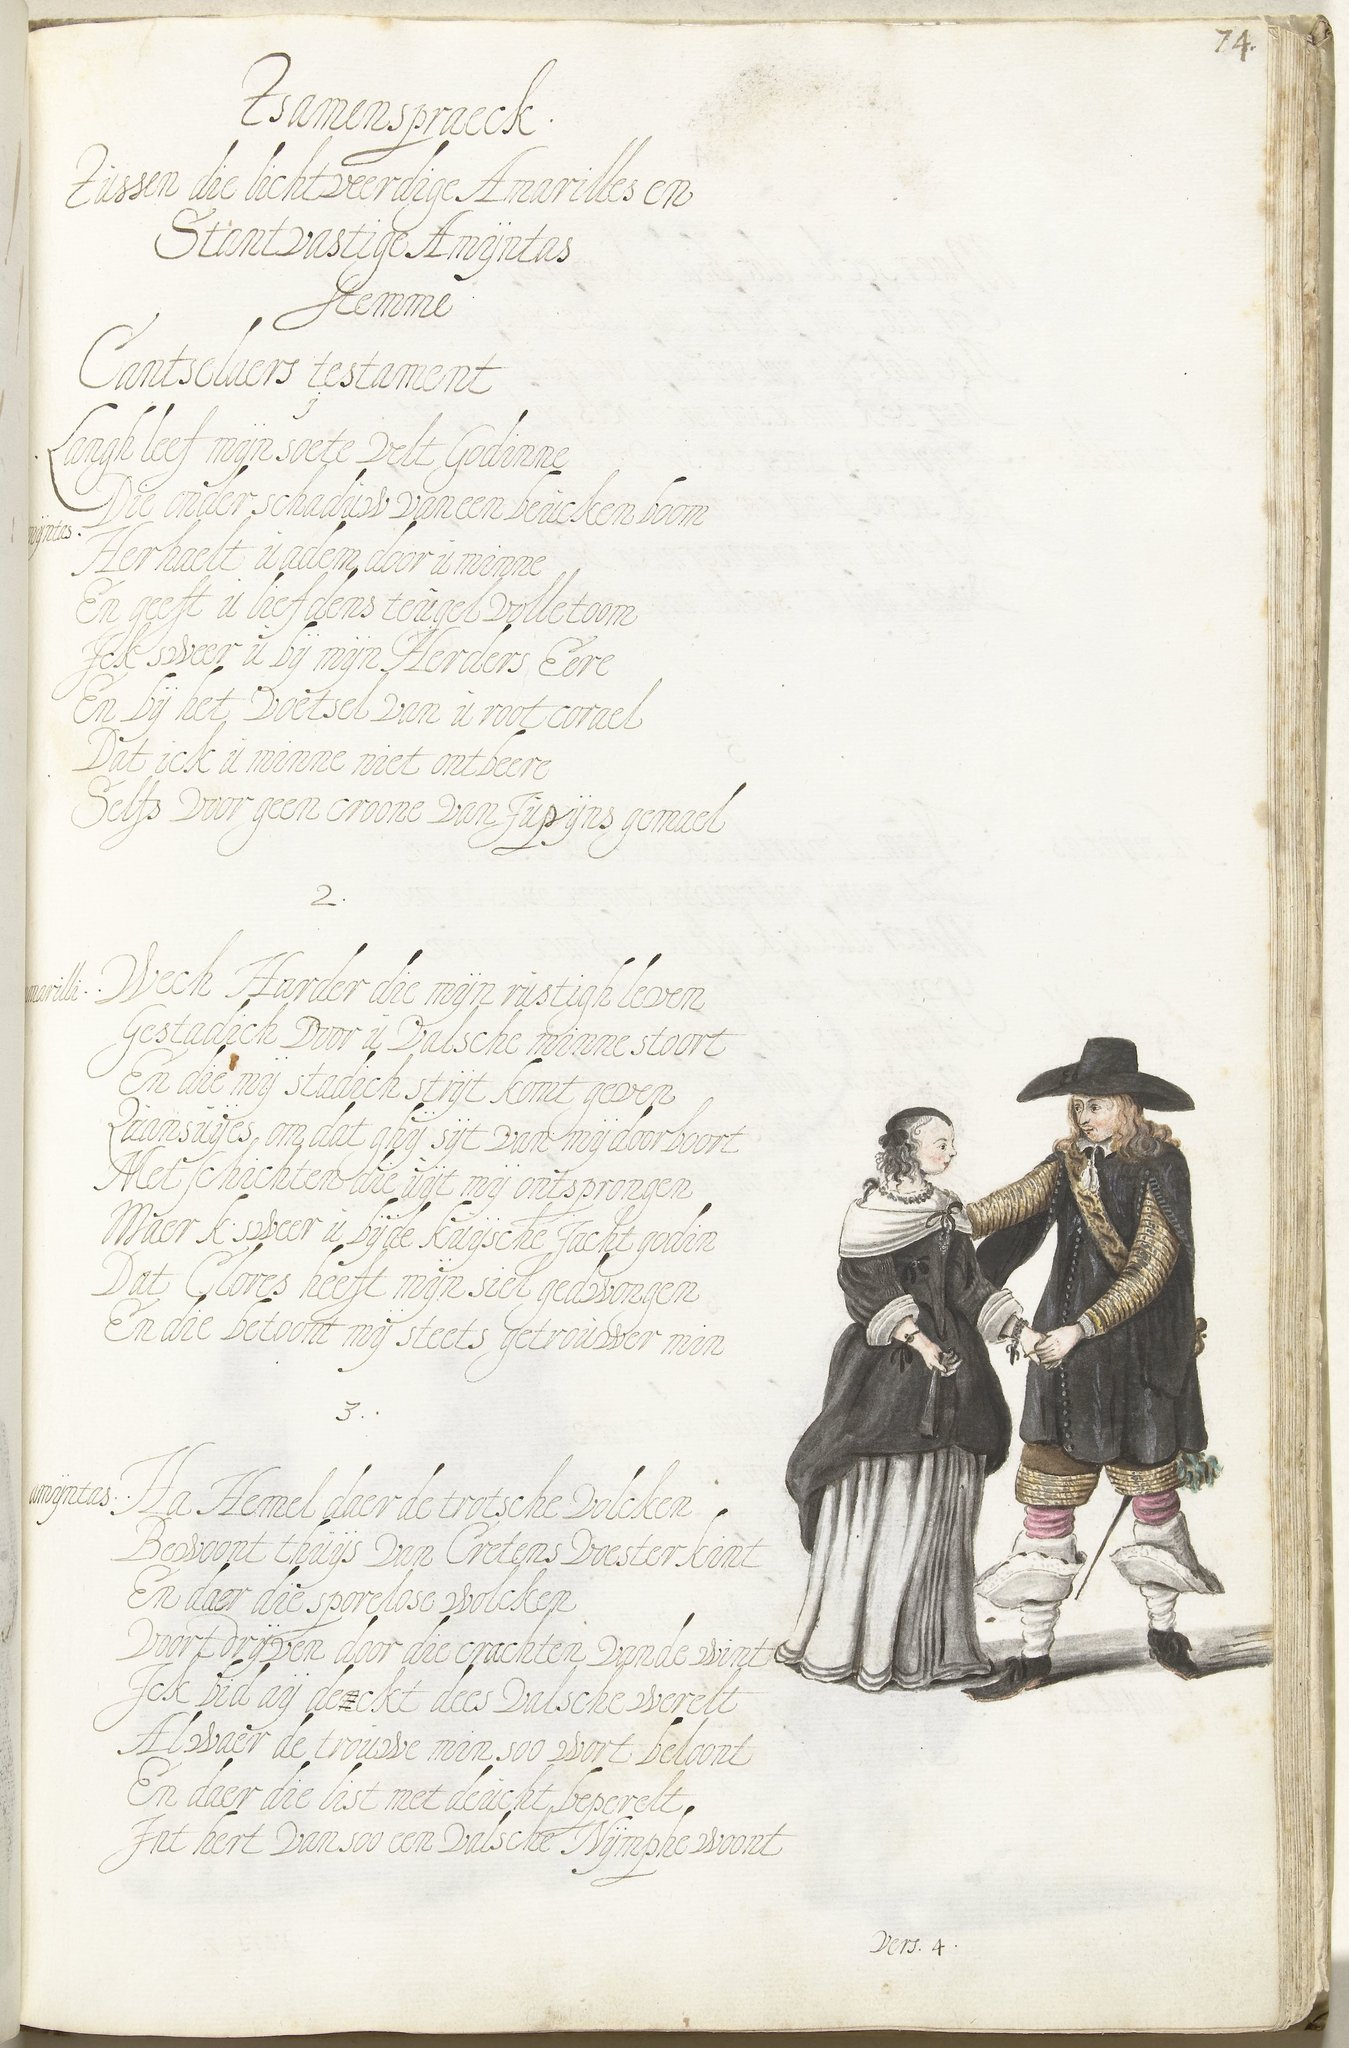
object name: poem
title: Tsamenspraeck tussen die lichtveerdige Amarilles en Stantvastige Amijntas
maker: gesina ter borch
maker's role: draughtsman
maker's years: 1633-1690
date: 1654-1658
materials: ink, paper, watercolor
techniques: brush, calligraphy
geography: zwolle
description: Dame en een officier naast gedicht (samen-spraeck) met dialoog tussen Amarilli en Amijntas, op de melodie van Cantselaers testament.